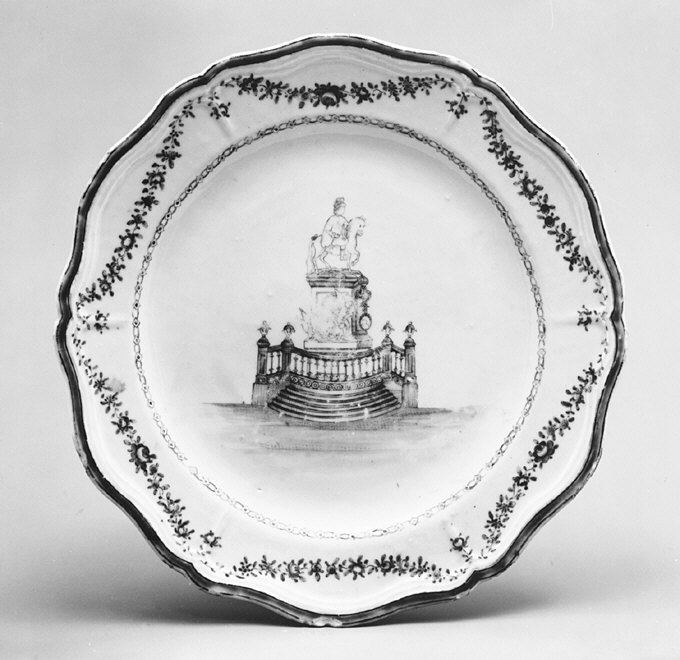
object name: plate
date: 1775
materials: hard paste porcelain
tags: horses